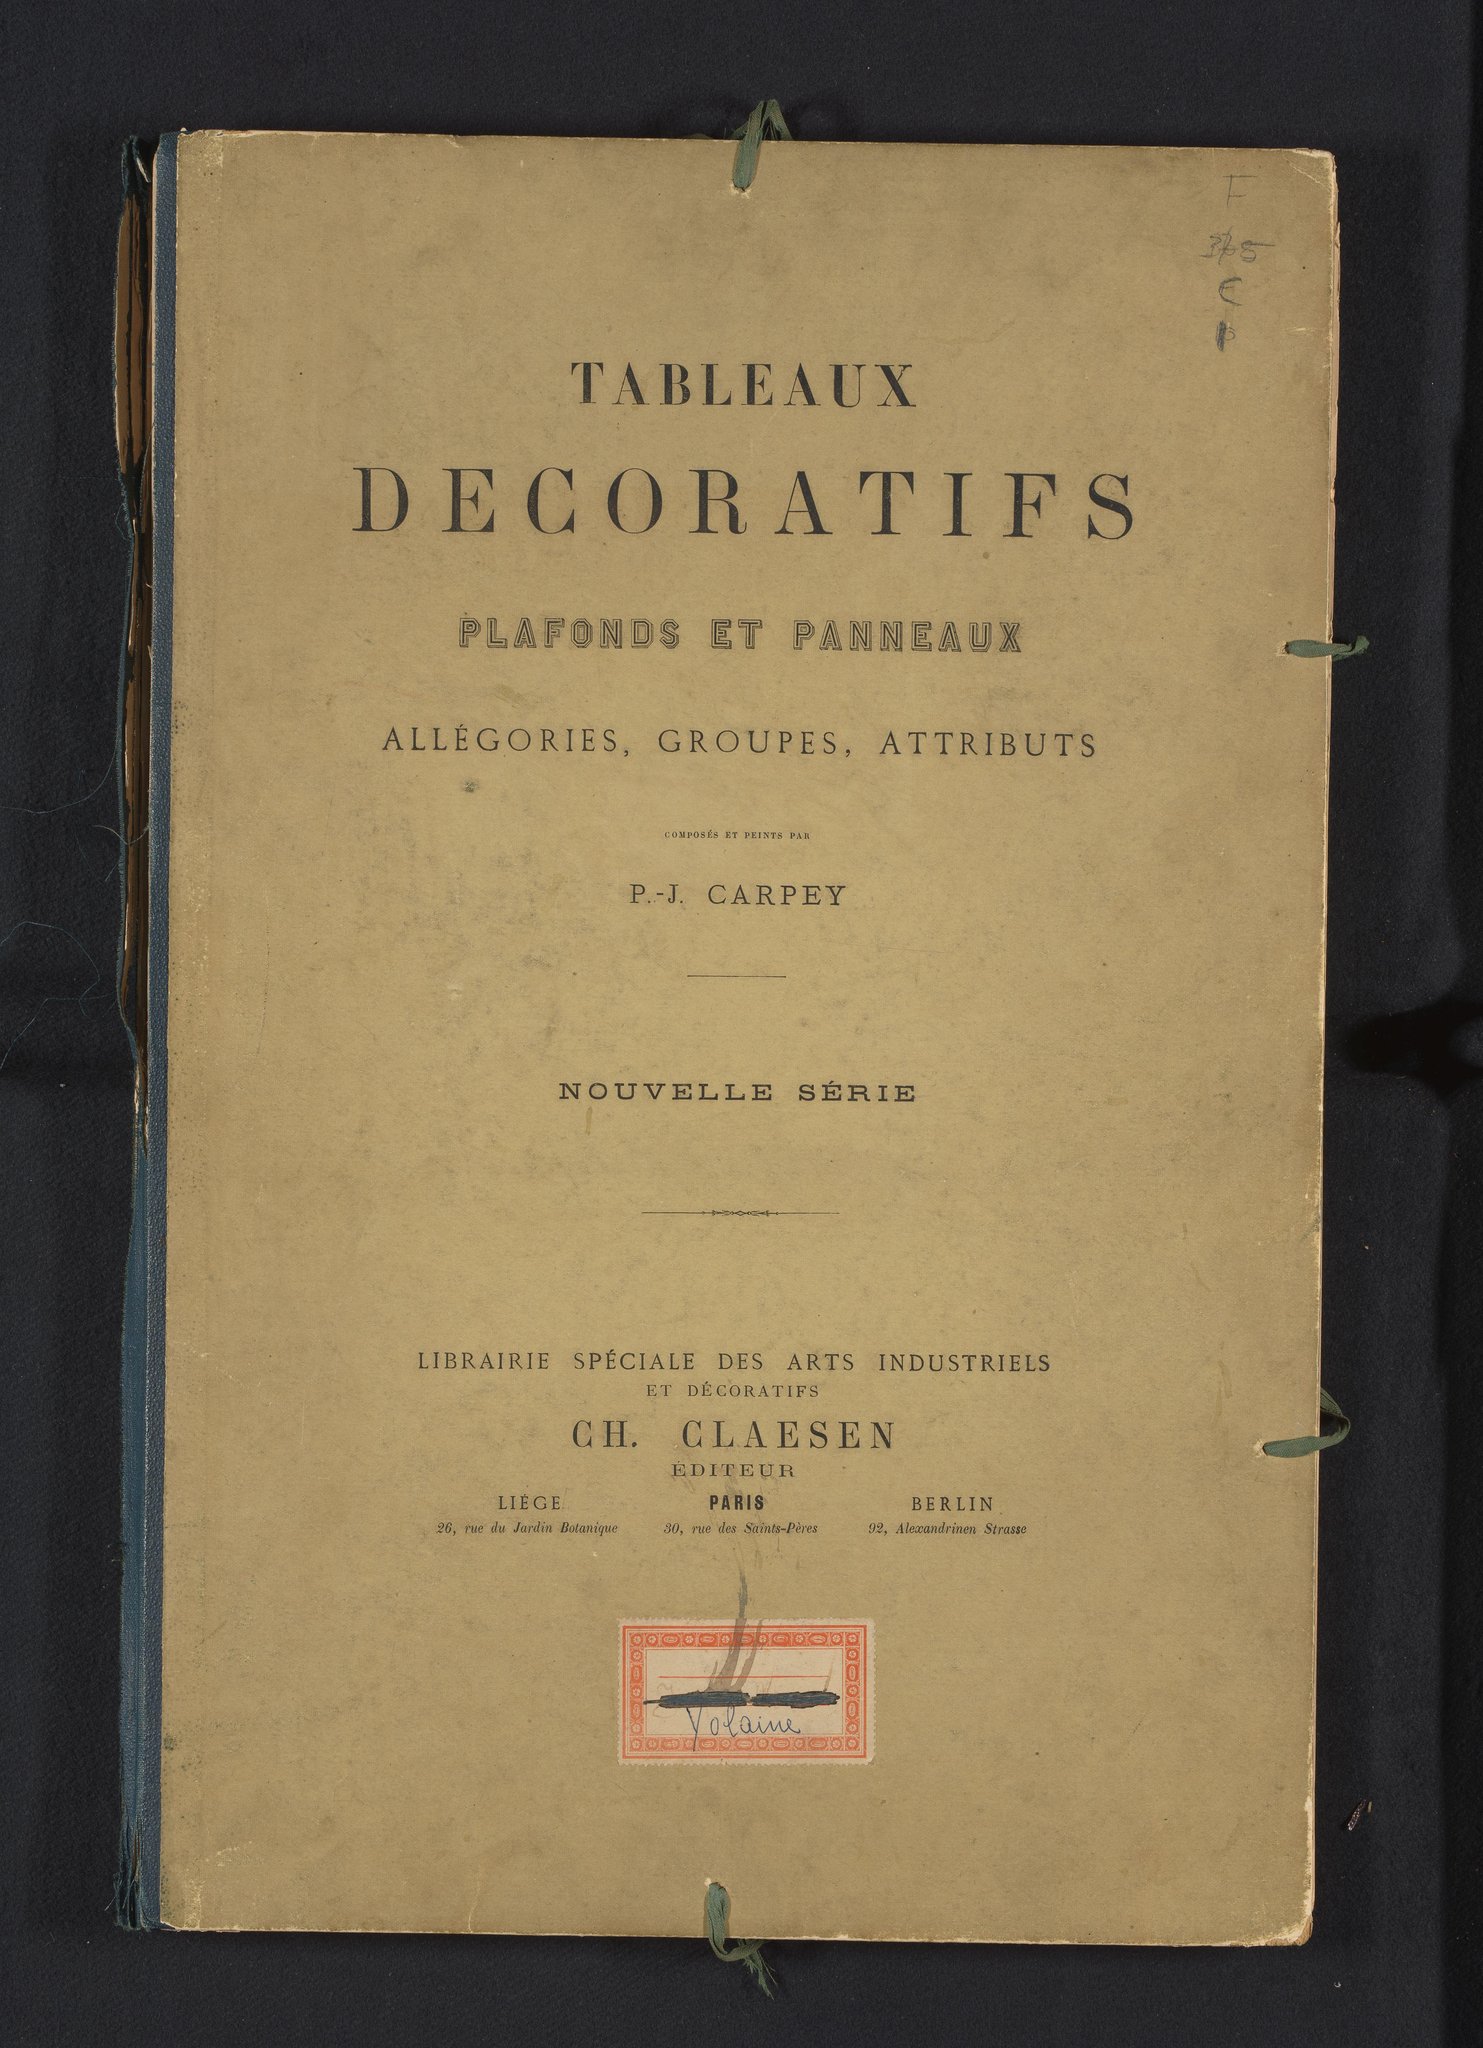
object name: wrapper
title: Tableaux decoratifs : plafonds et panneaux : allégories, groupes, attributs. Nouv. sér. / composés et peints par P.-J. Carpey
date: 1879-1881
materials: cardboard, linen, paper, photographic support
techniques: albumen print, printing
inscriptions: date: ‘SEPT/ 2009’, name: ‘Yolaine’